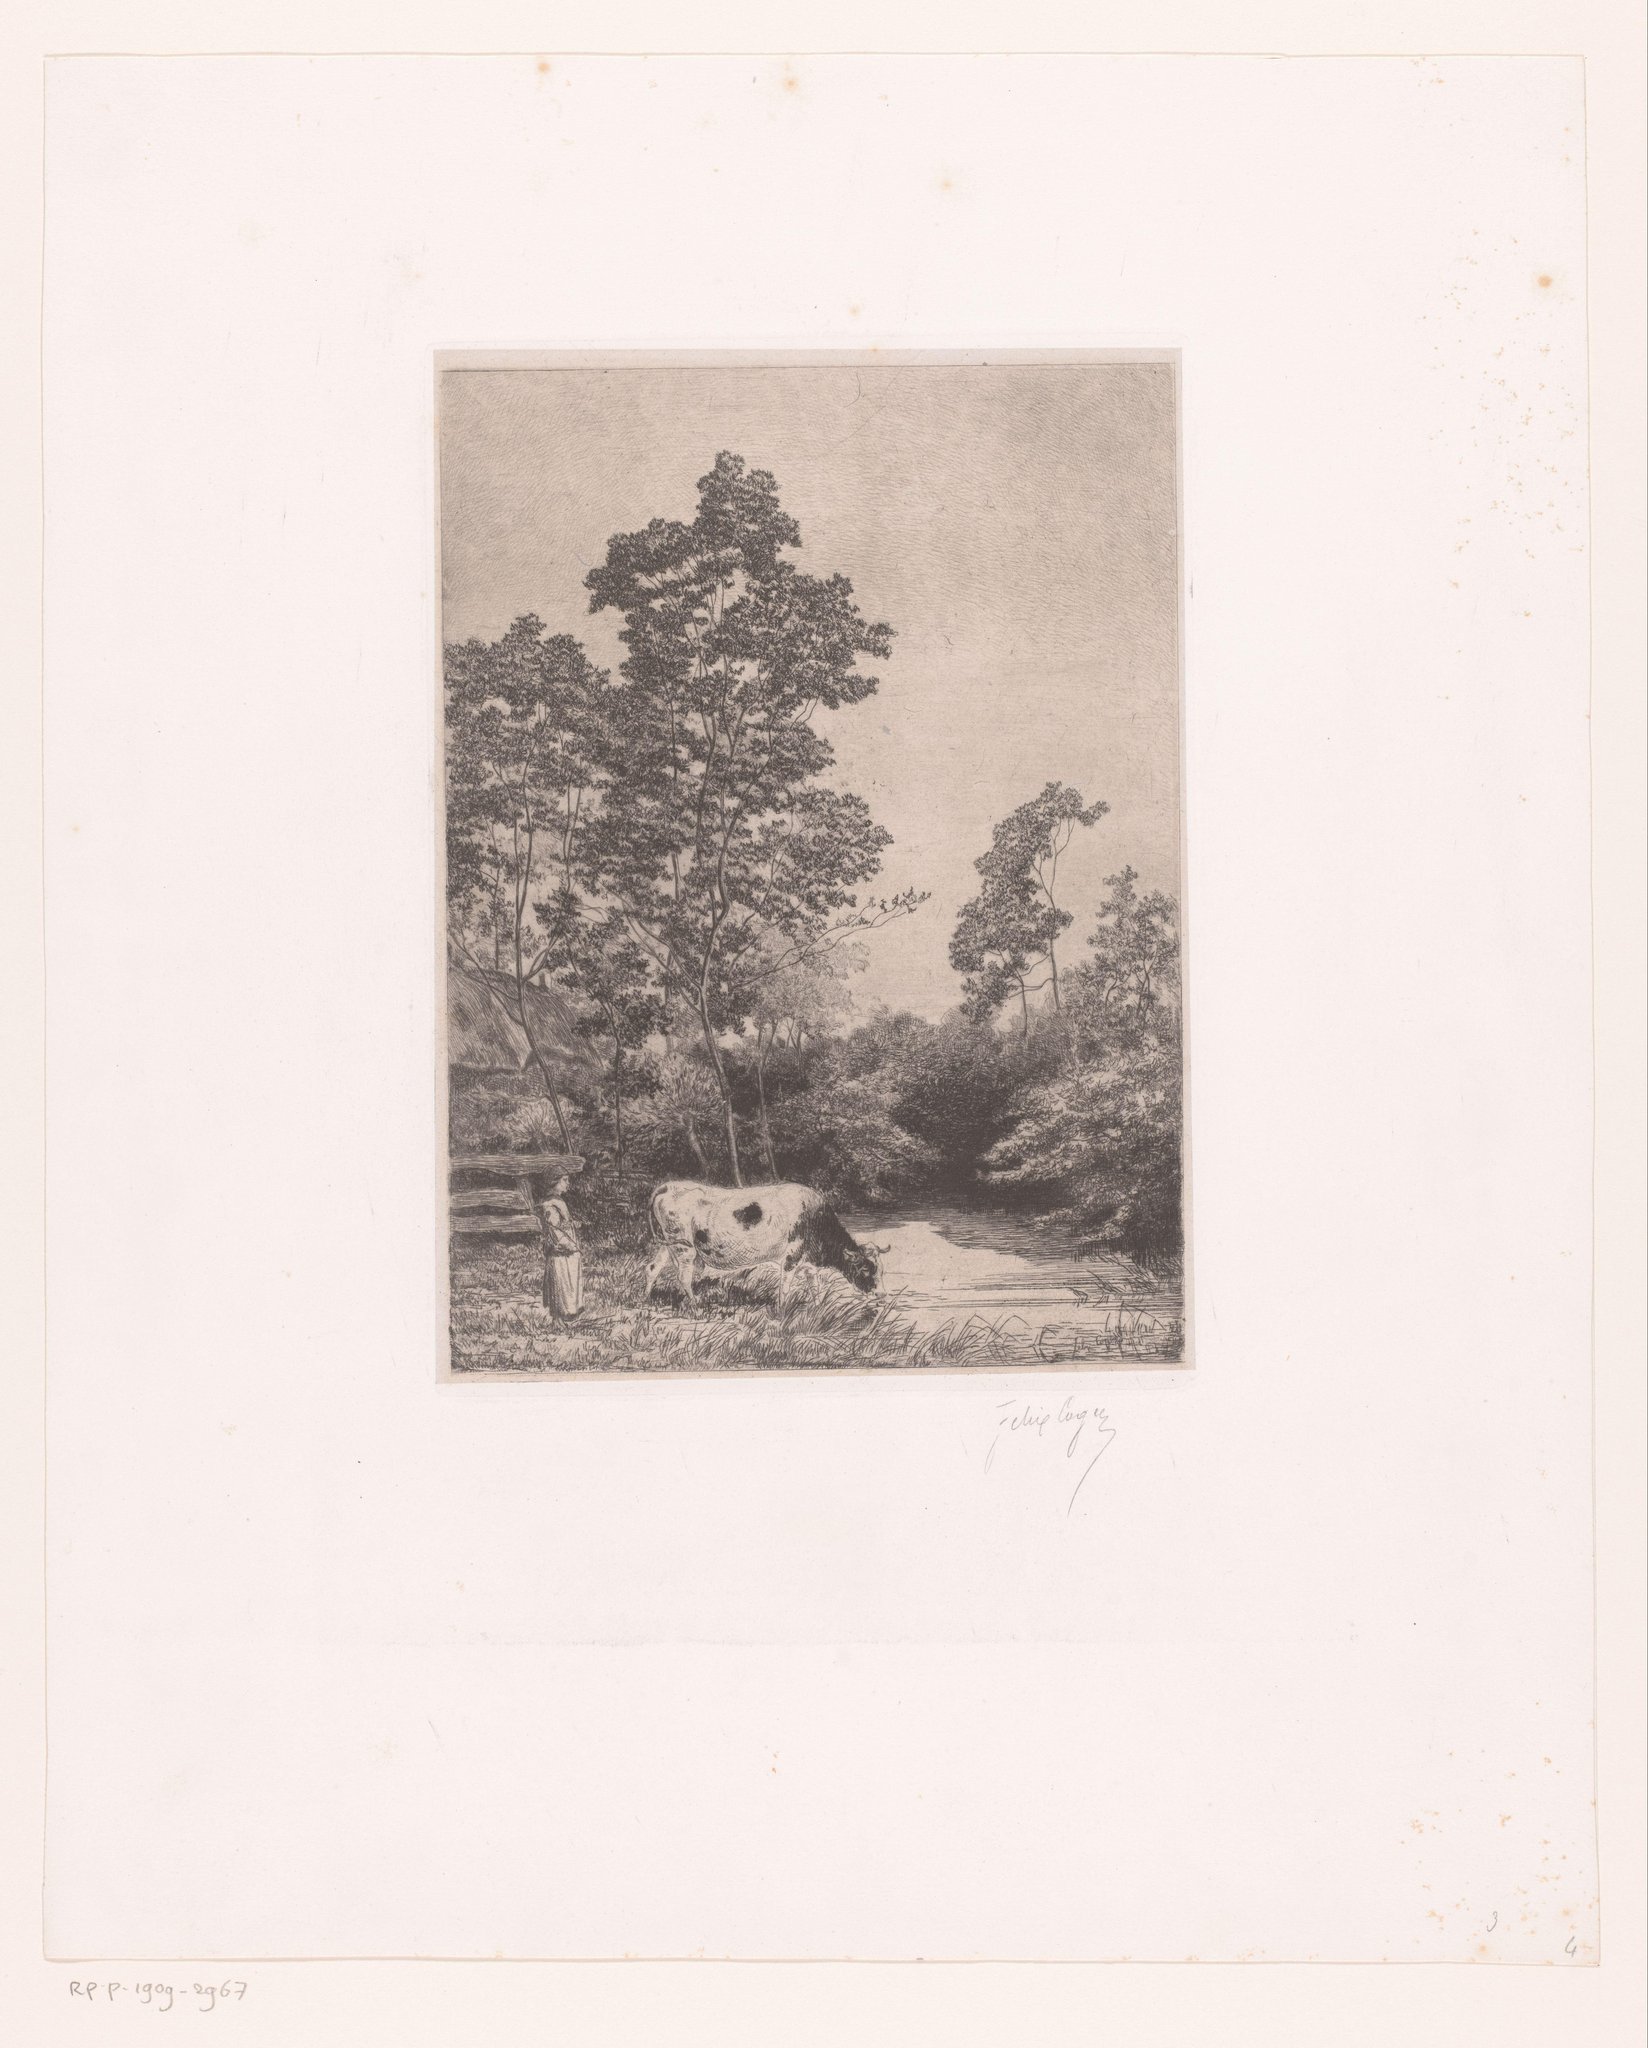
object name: print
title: Drinkende koe langs de oever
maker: félix cogen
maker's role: print maker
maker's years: 1838-1907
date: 1876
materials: paper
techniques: etching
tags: cow, river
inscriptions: collector's mark